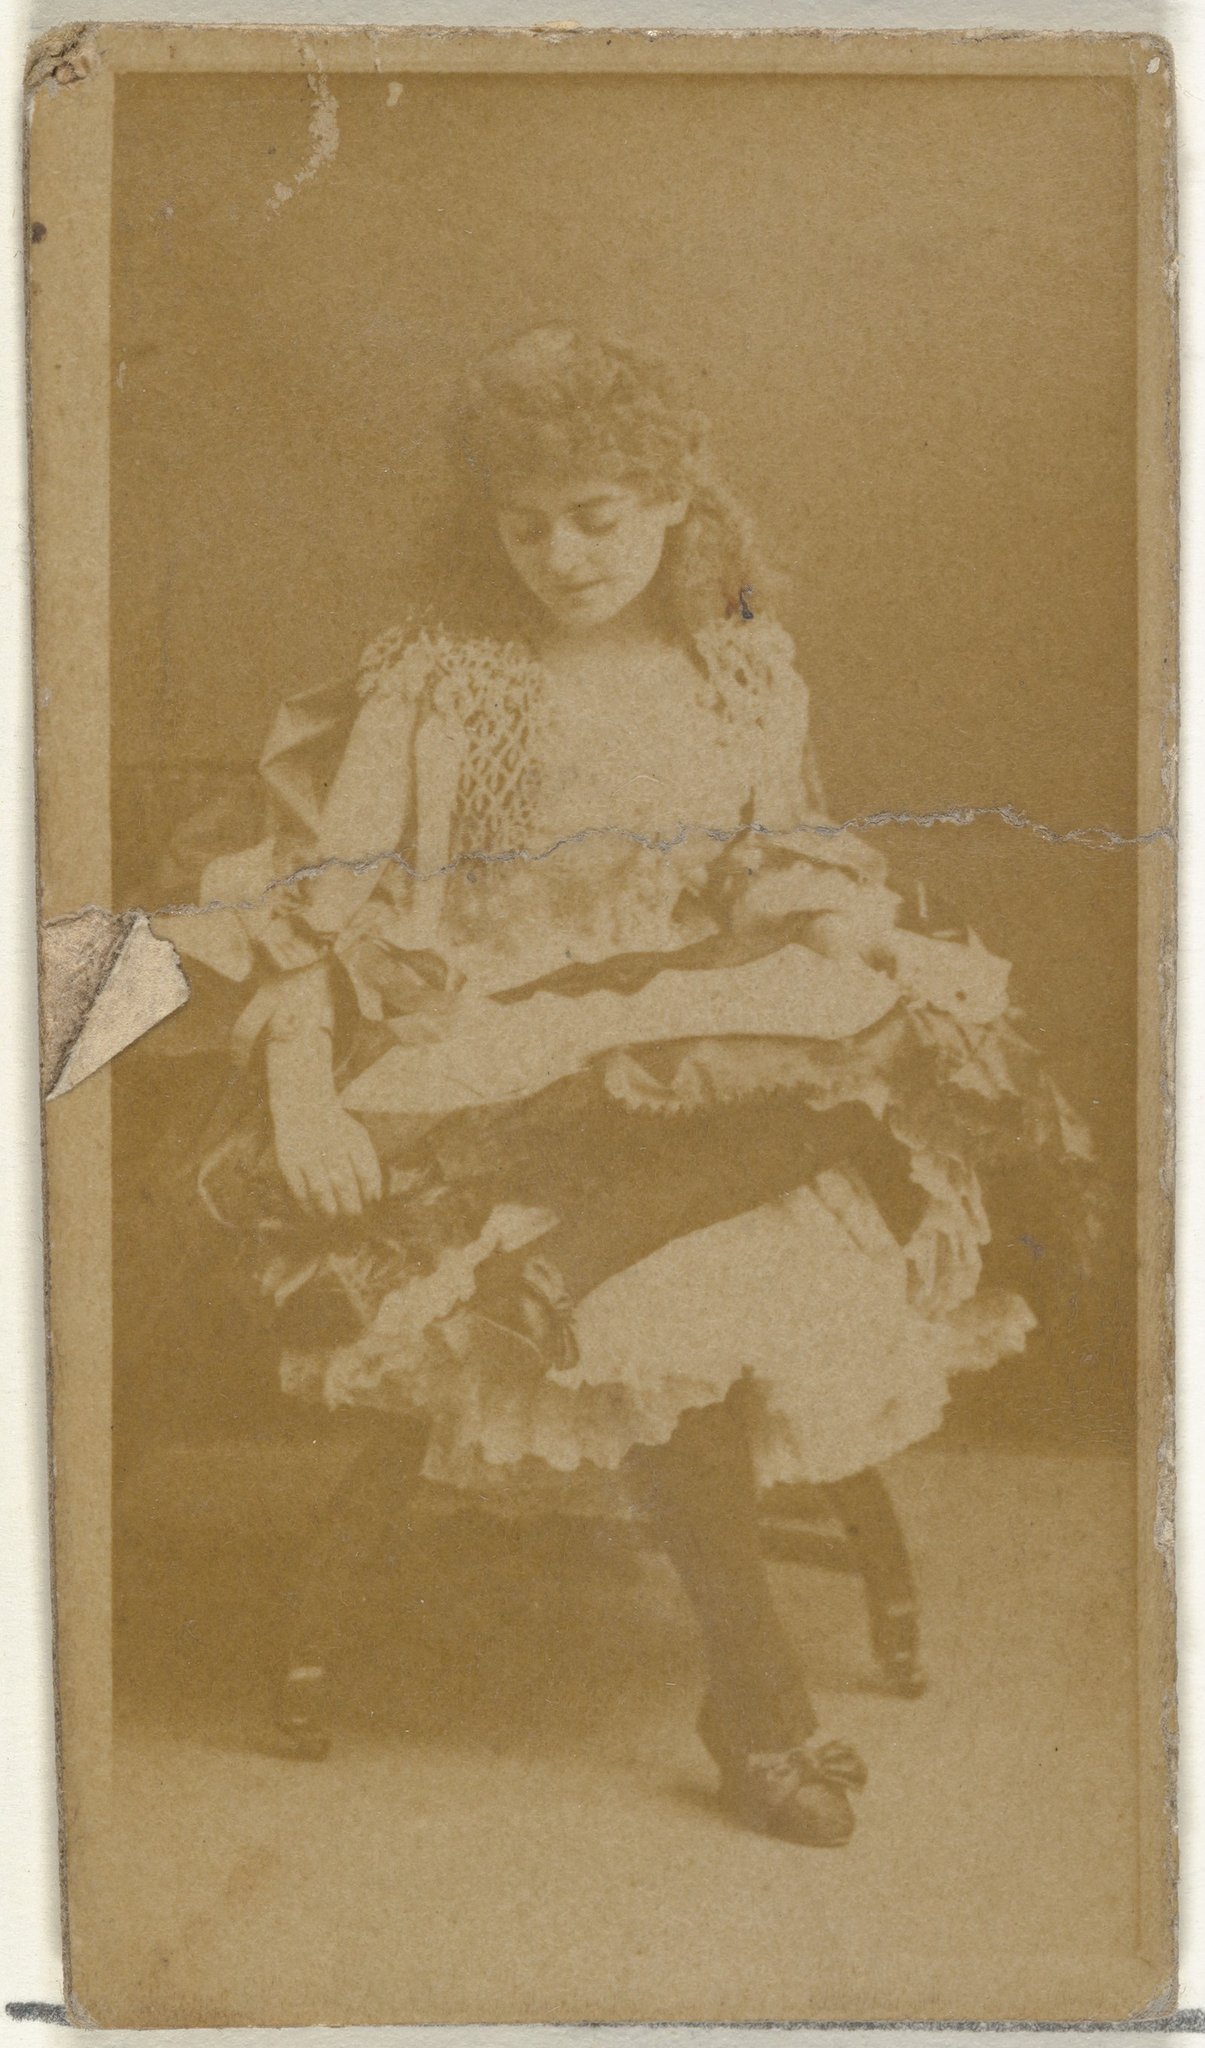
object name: photograph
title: [Seated actress, looking down], from the Actors and Actresses series (N145-8) issued by Duke Sons & Co. to promote Duke Cigarettes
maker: w. duke, sons & co.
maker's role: publisher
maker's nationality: american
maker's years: 1870-1920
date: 1891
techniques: albumen silver print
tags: portraits,women,actresses